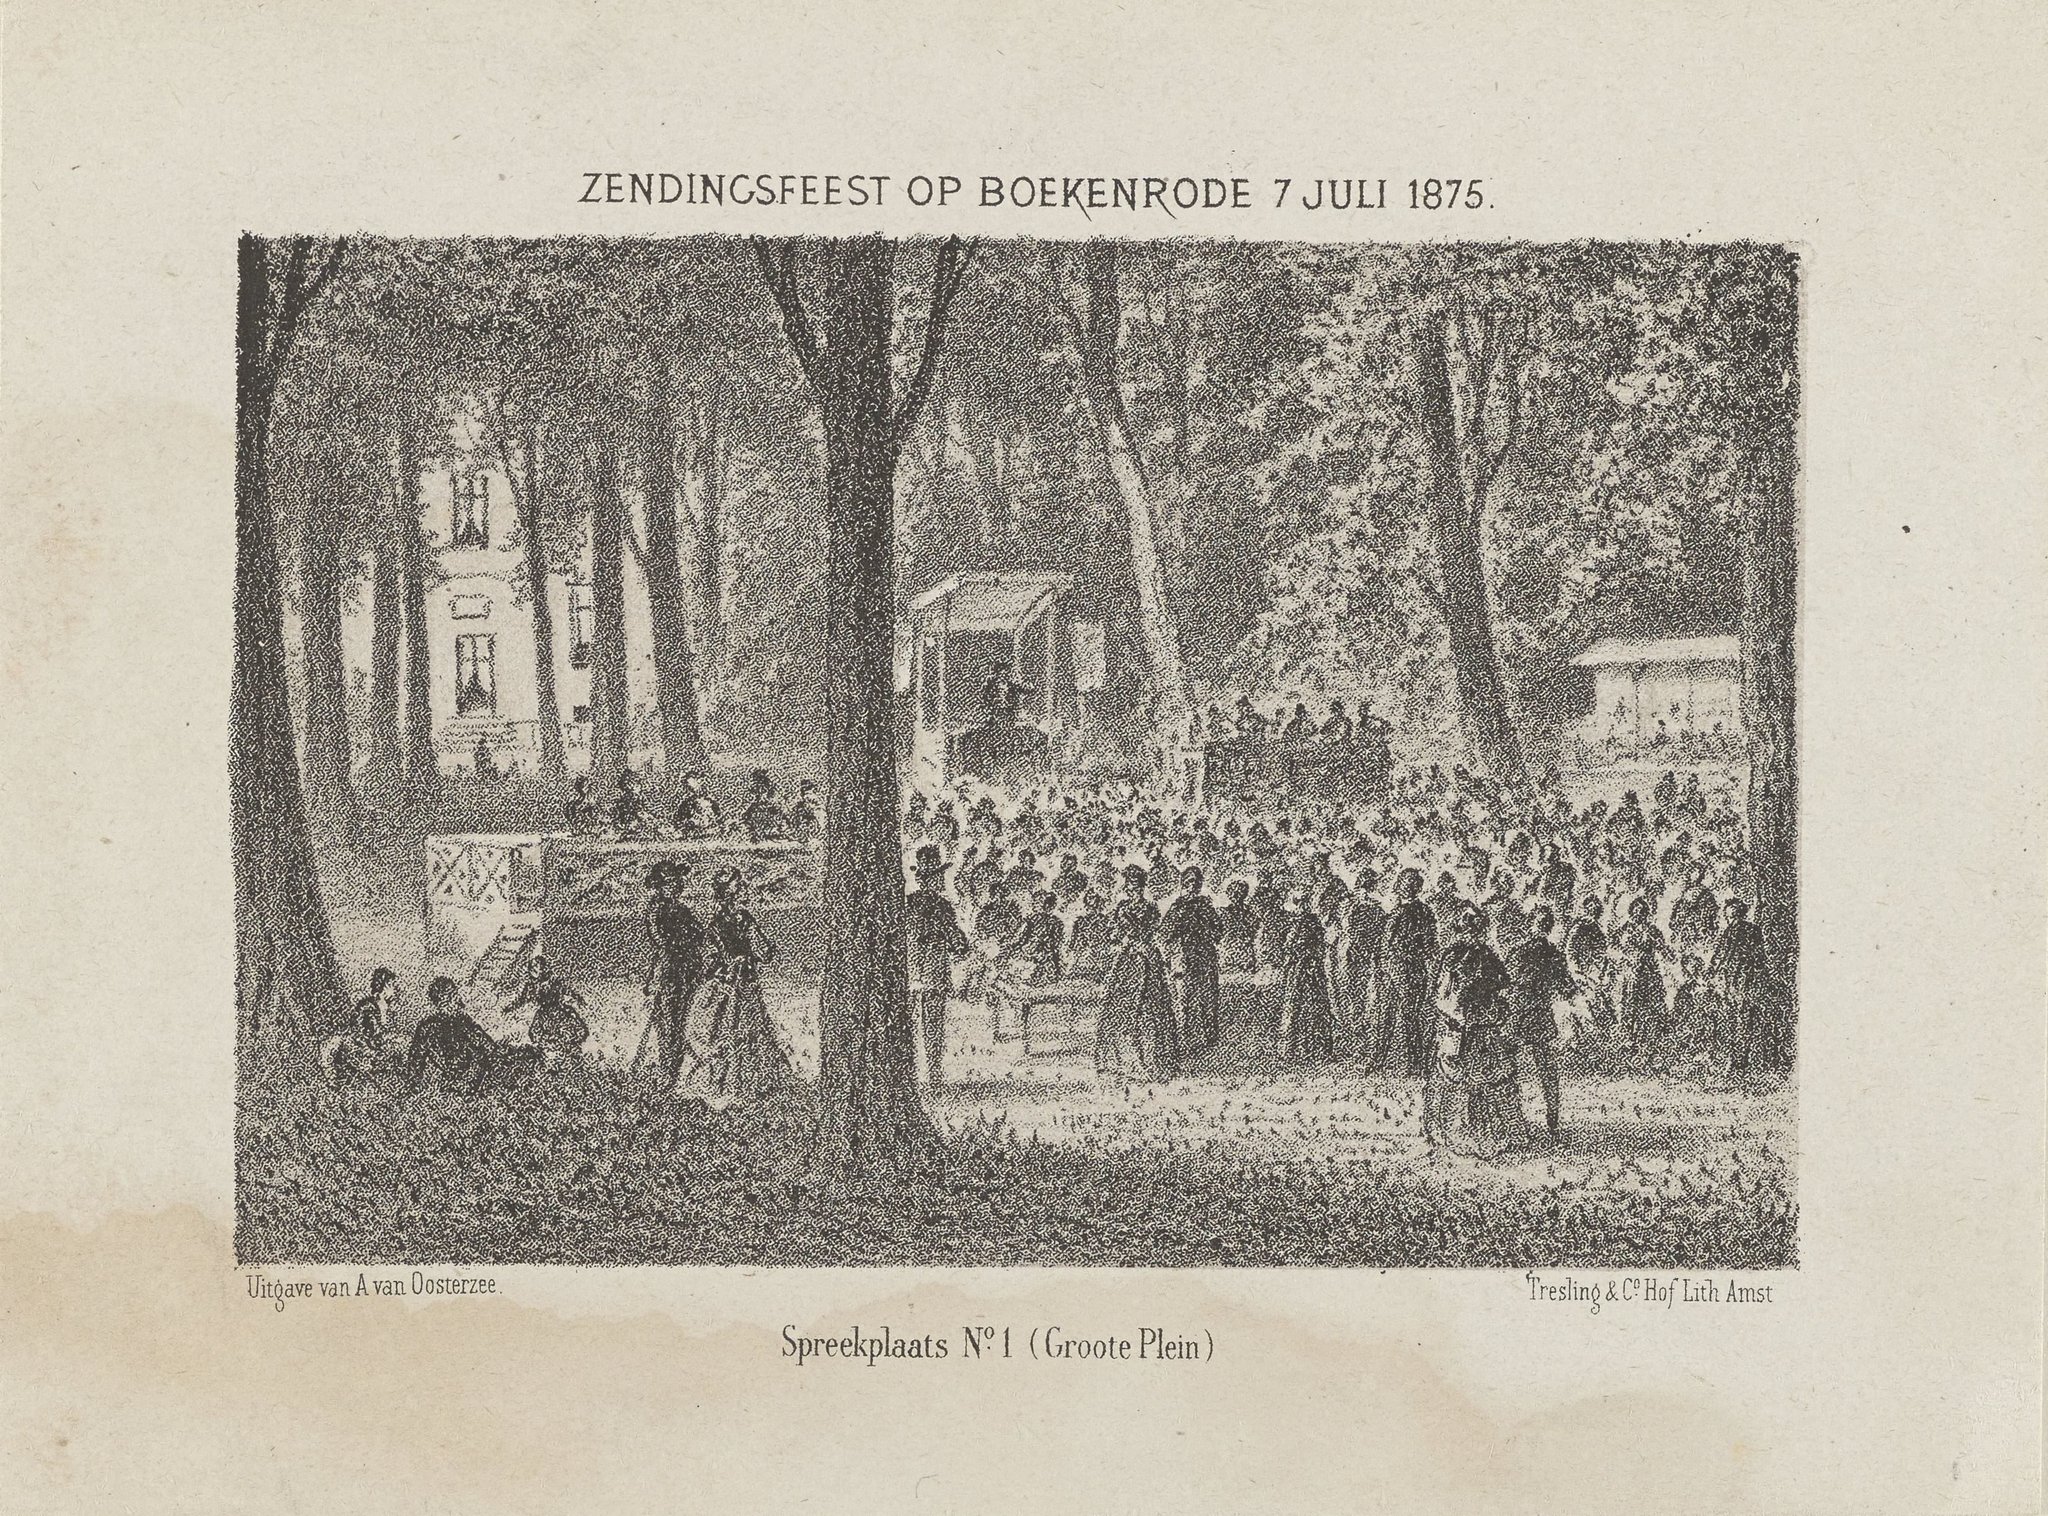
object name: print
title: Zendingsfeest op Boekenrode 7 Juli 1875 / Spreekplaats No. 1 (Groote Plein)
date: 1875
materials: paper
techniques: lithograph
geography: netherlands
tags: address, talk, lecture (~ meeting), spreading the gospel; missionary work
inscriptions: collector's mark: Lugt 2228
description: Een man spreekt een grote groep mensen toe, tijdens het Twaalfde Christelijk Nationaal Zendingsfeest in de tuin van Huis Boekenrode in Aerdenhout bij Haarlem, 7 juli 1875.